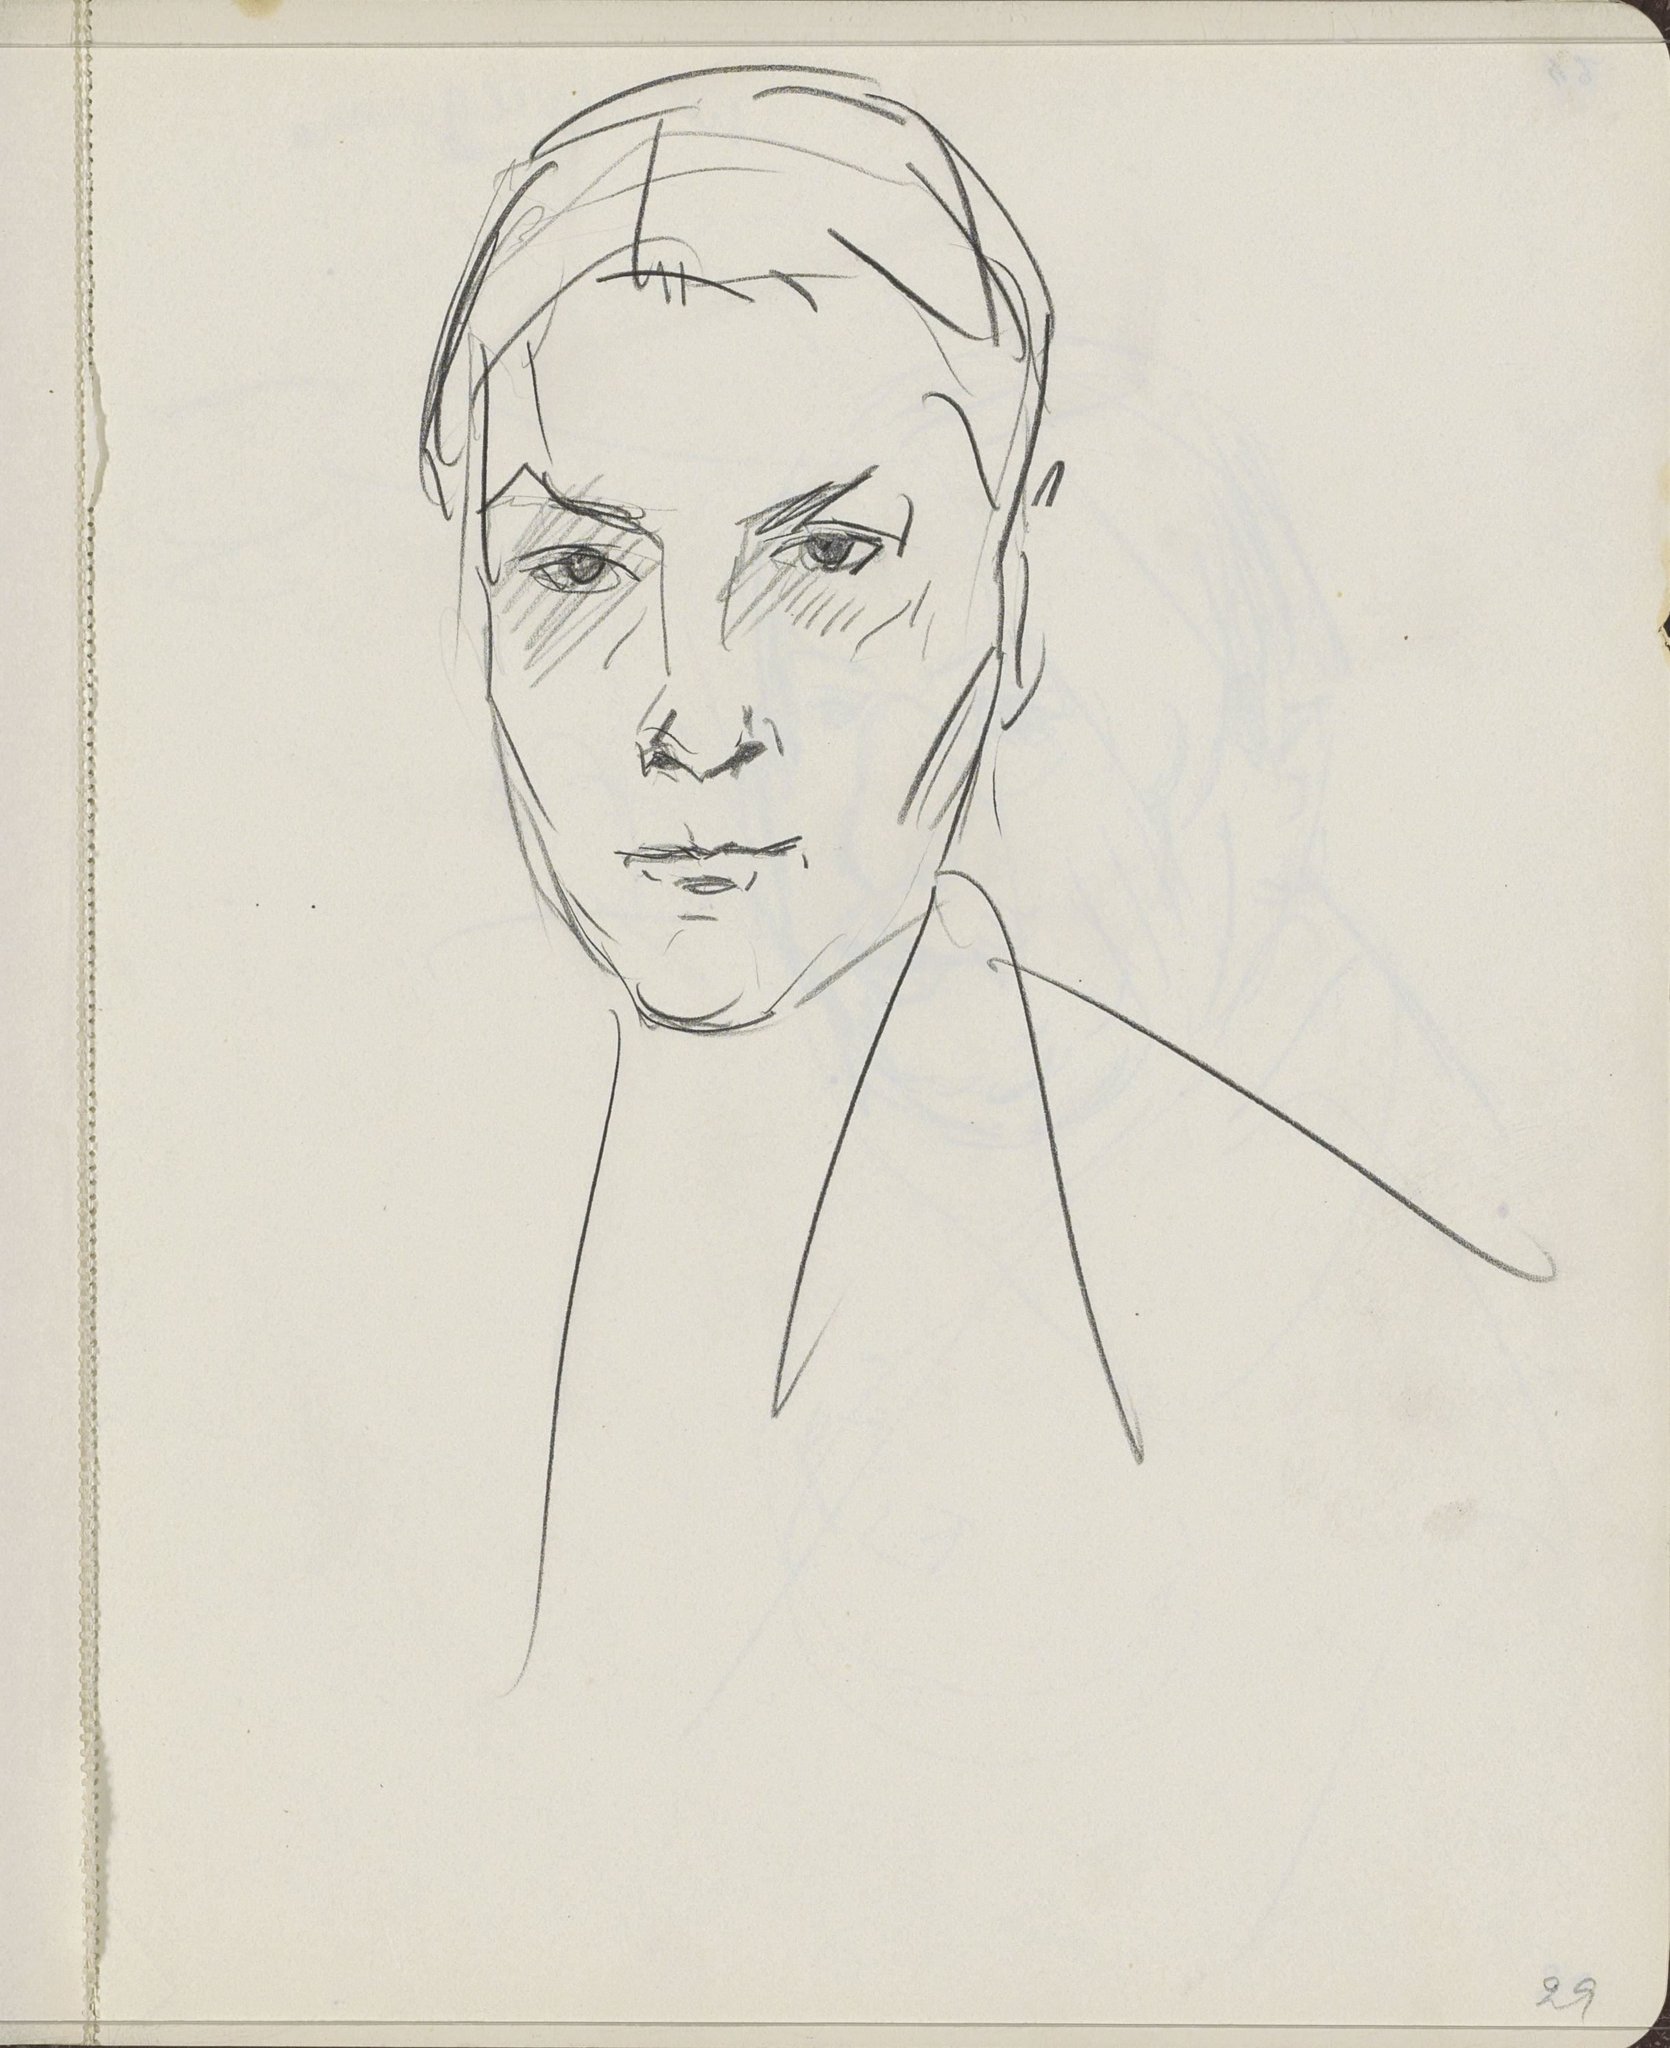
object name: sketchbook leaf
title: Hoofd van een man of vrouw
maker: isaac israels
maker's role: draughtsman, painter, print maker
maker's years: 1865-1934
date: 1925-1934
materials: paper, pencil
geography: the hague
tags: adult man (+ sitting)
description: Blad 29 recto uit schetsboek XXVI met 35 bladen.